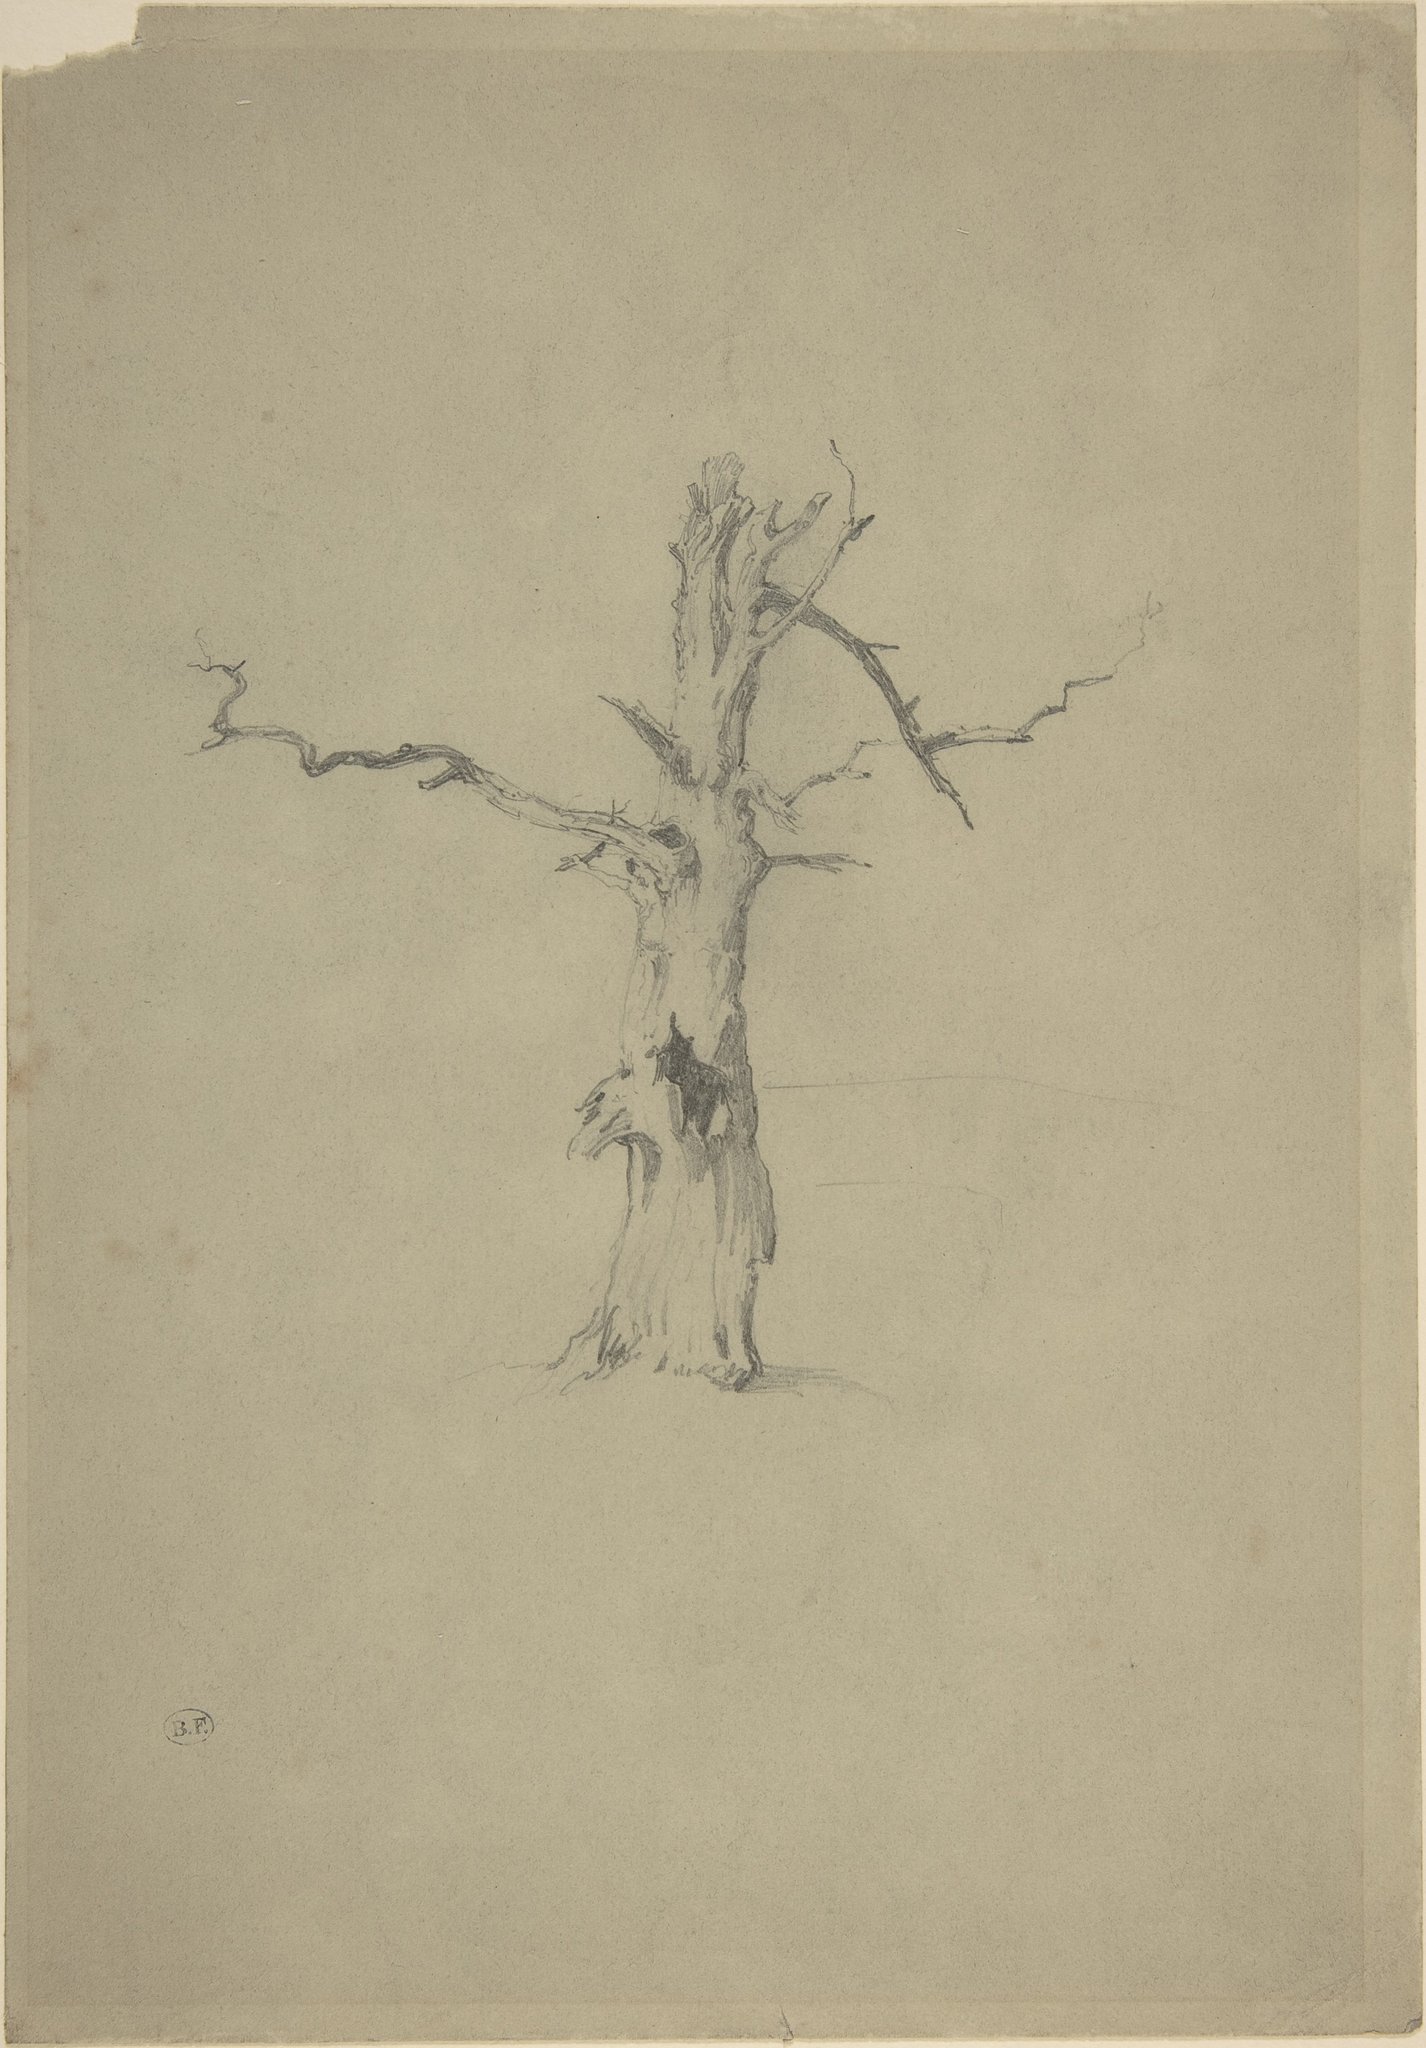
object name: drawing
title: Study of a Dead Tree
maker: myles birket foster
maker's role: artist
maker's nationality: british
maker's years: 1825-1899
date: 1840-1899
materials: graphite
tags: trees